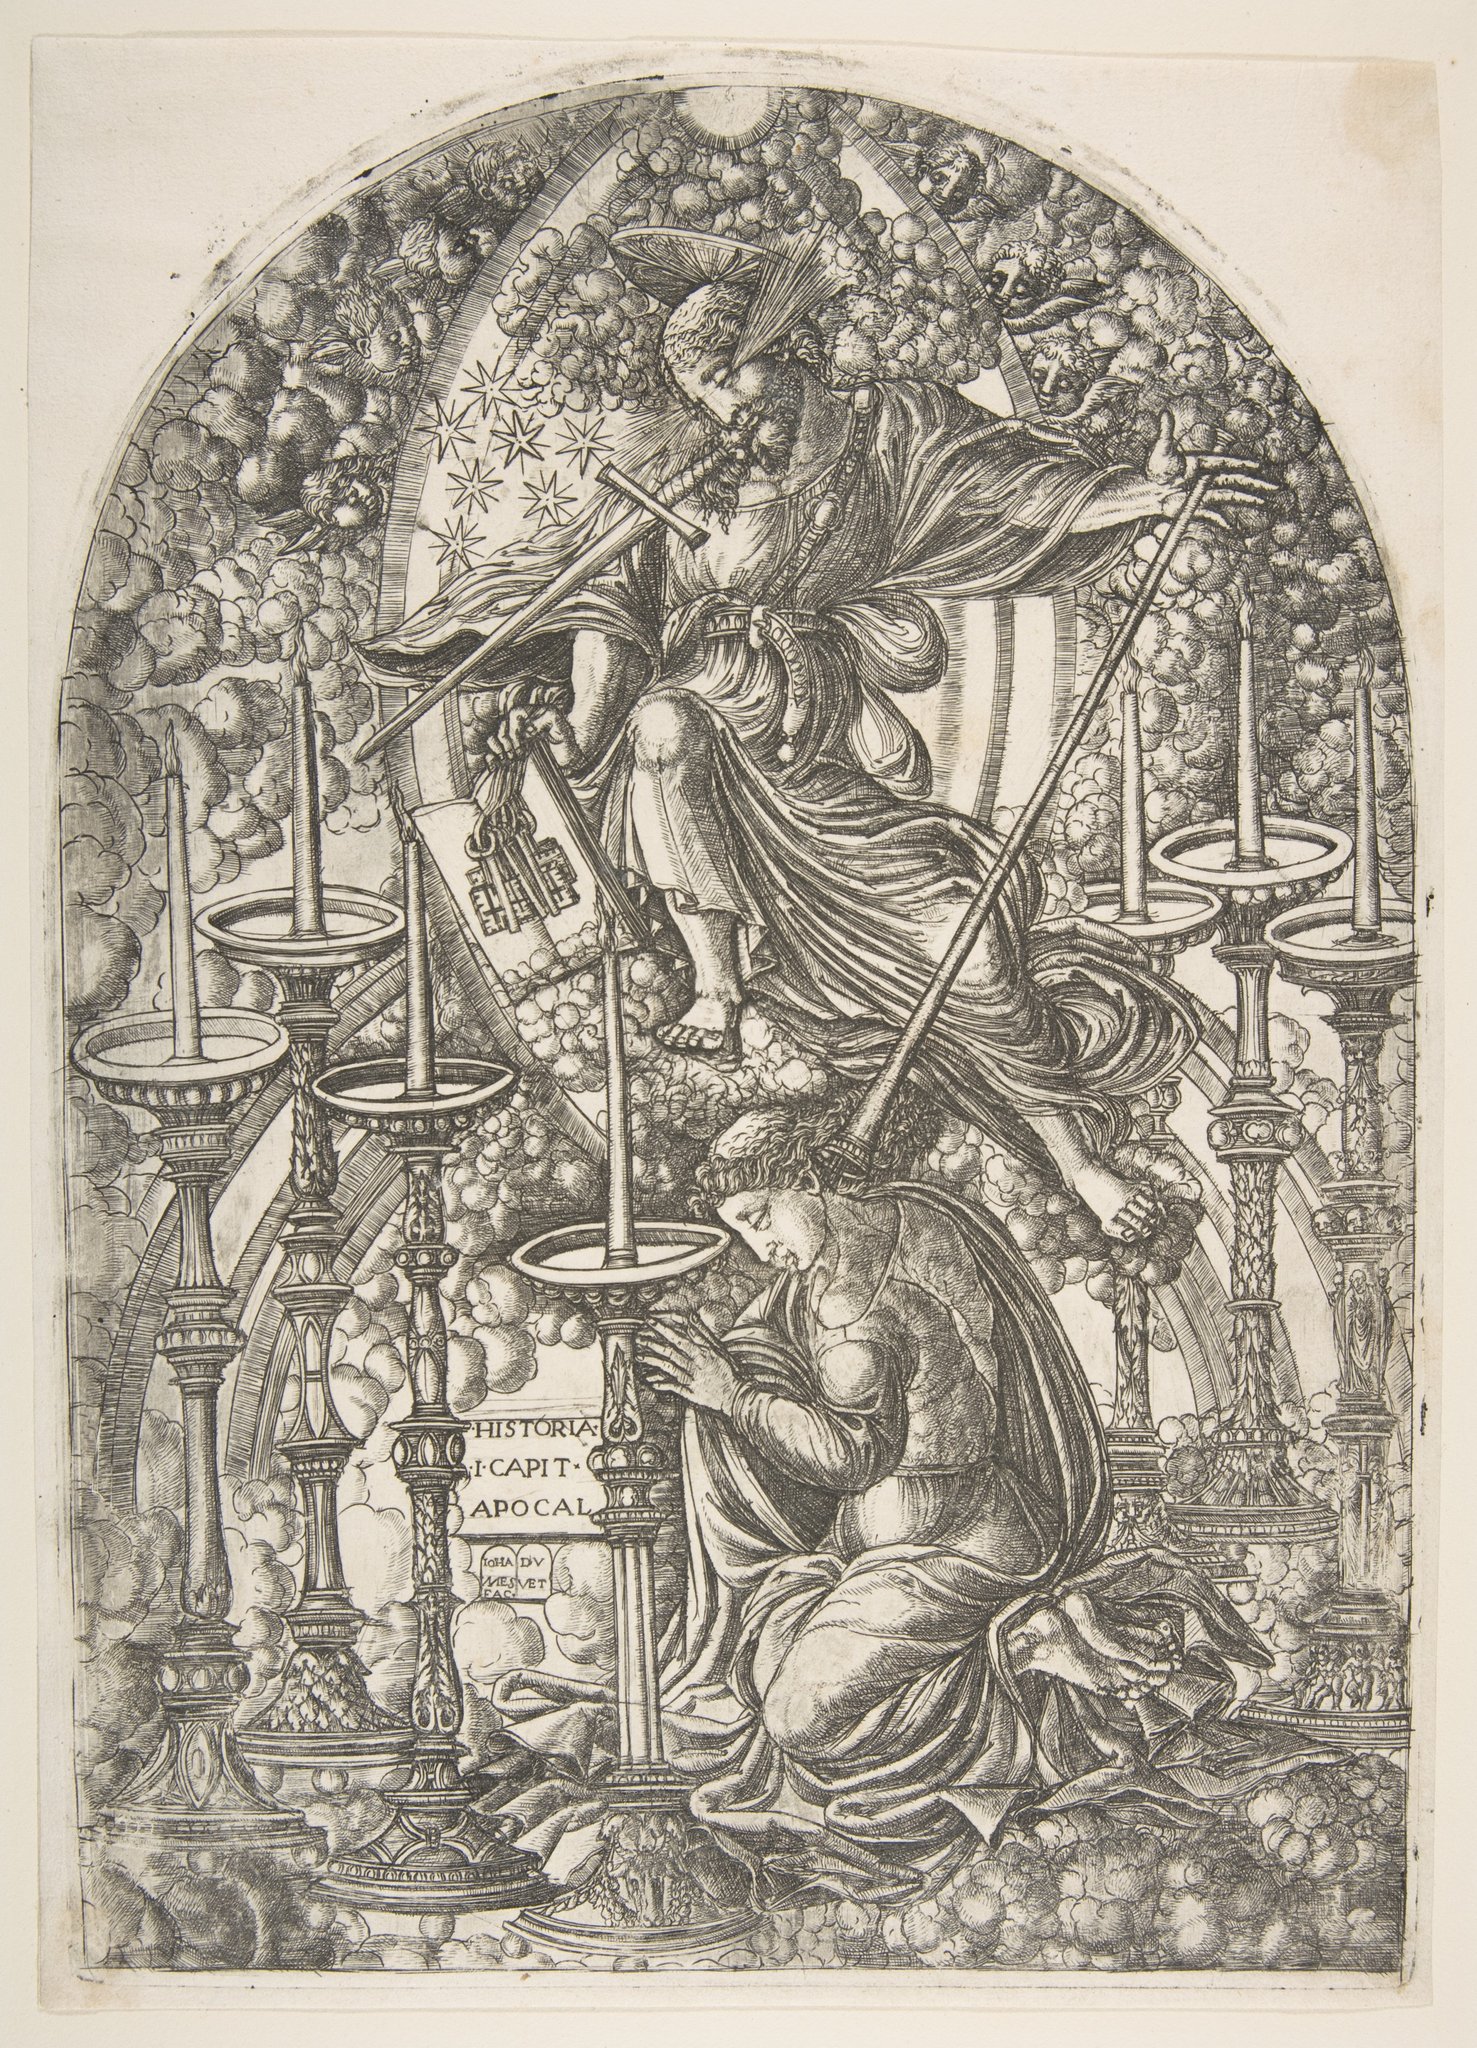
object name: print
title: Saint John sees Seven Gold Candlesticks, from the Apocalypse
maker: jean duvet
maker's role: artist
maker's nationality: french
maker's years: 1485-1561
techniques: engraving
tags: saint john the baptist,apocalypse